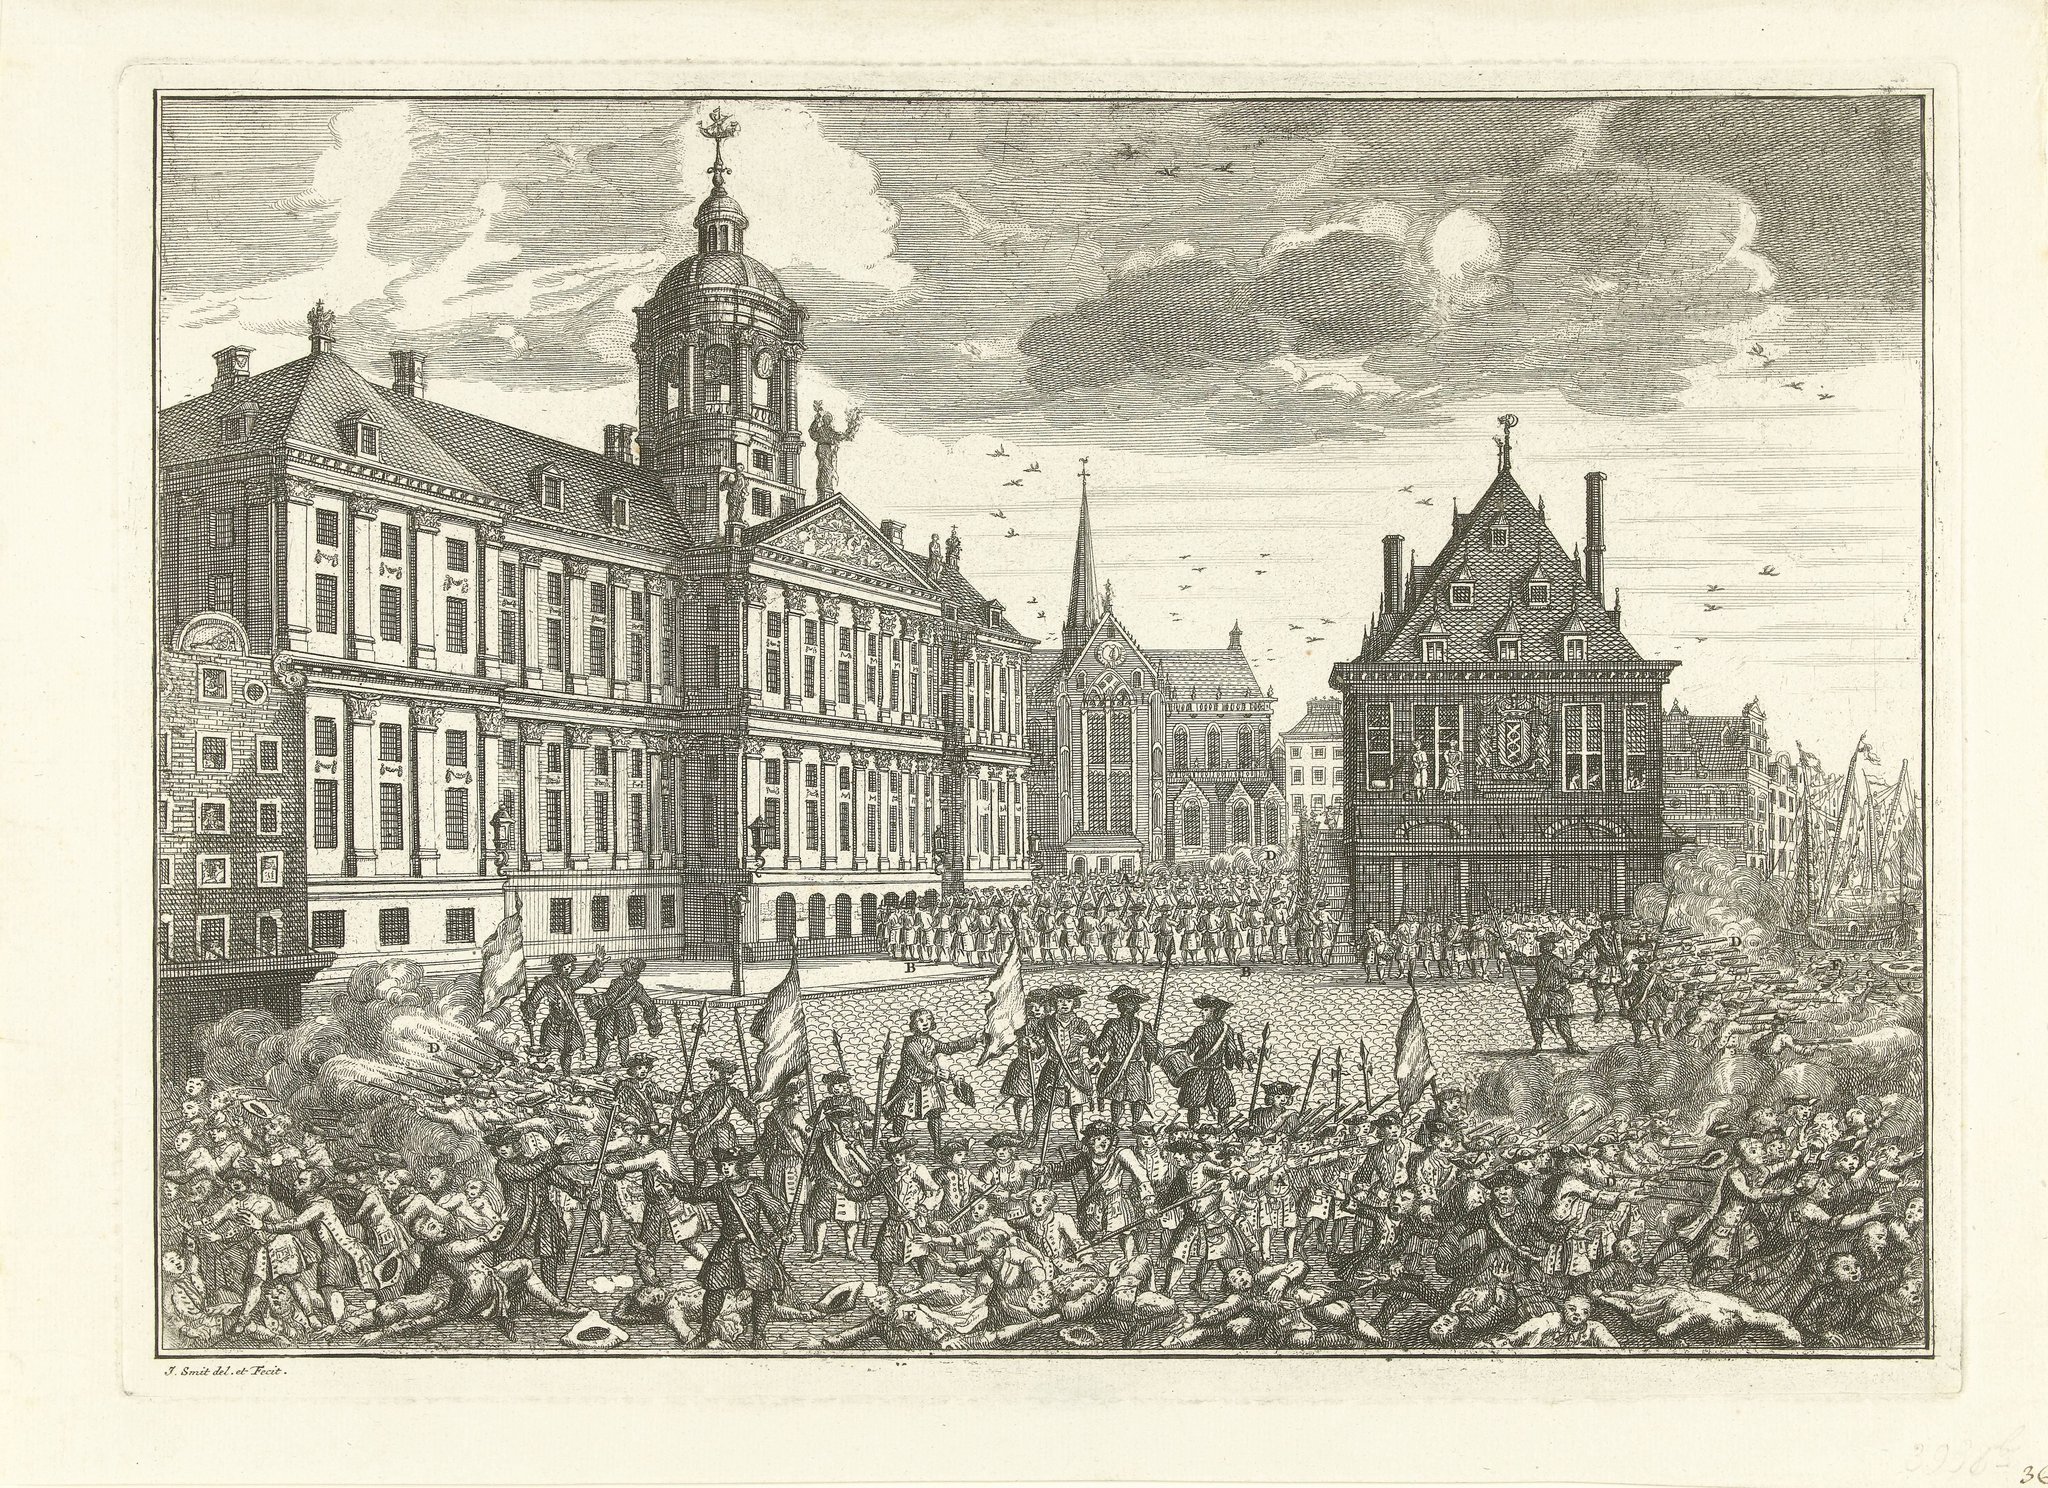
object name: print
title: Executies en oproer op de Dam, 1748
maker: jan smit (ii)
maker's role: print maker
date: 1748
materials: paper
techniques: etching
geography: northern netherlands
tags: anti-riot measures, violent death by hanging, street-fights, riots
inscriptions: collector's mark: Lugt 2228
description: Gezicht op de Dam met het stadhuis, de Nieuwe Kerk, de Waag en het Damrak, met het schieten door de burgerwacht in de rijen van de opdringende toeschouwers op de Dam, 28 juni 1748. Aan de Waag hangen de lichamen van de terechtgestelde man en een vrouw (Piet van Dort en de citroen- en gedroogde scholverkoopster Mat van den Nieuwendijk) wegens hun rol in het Pachtersoproer. Zonder het onderschrift.